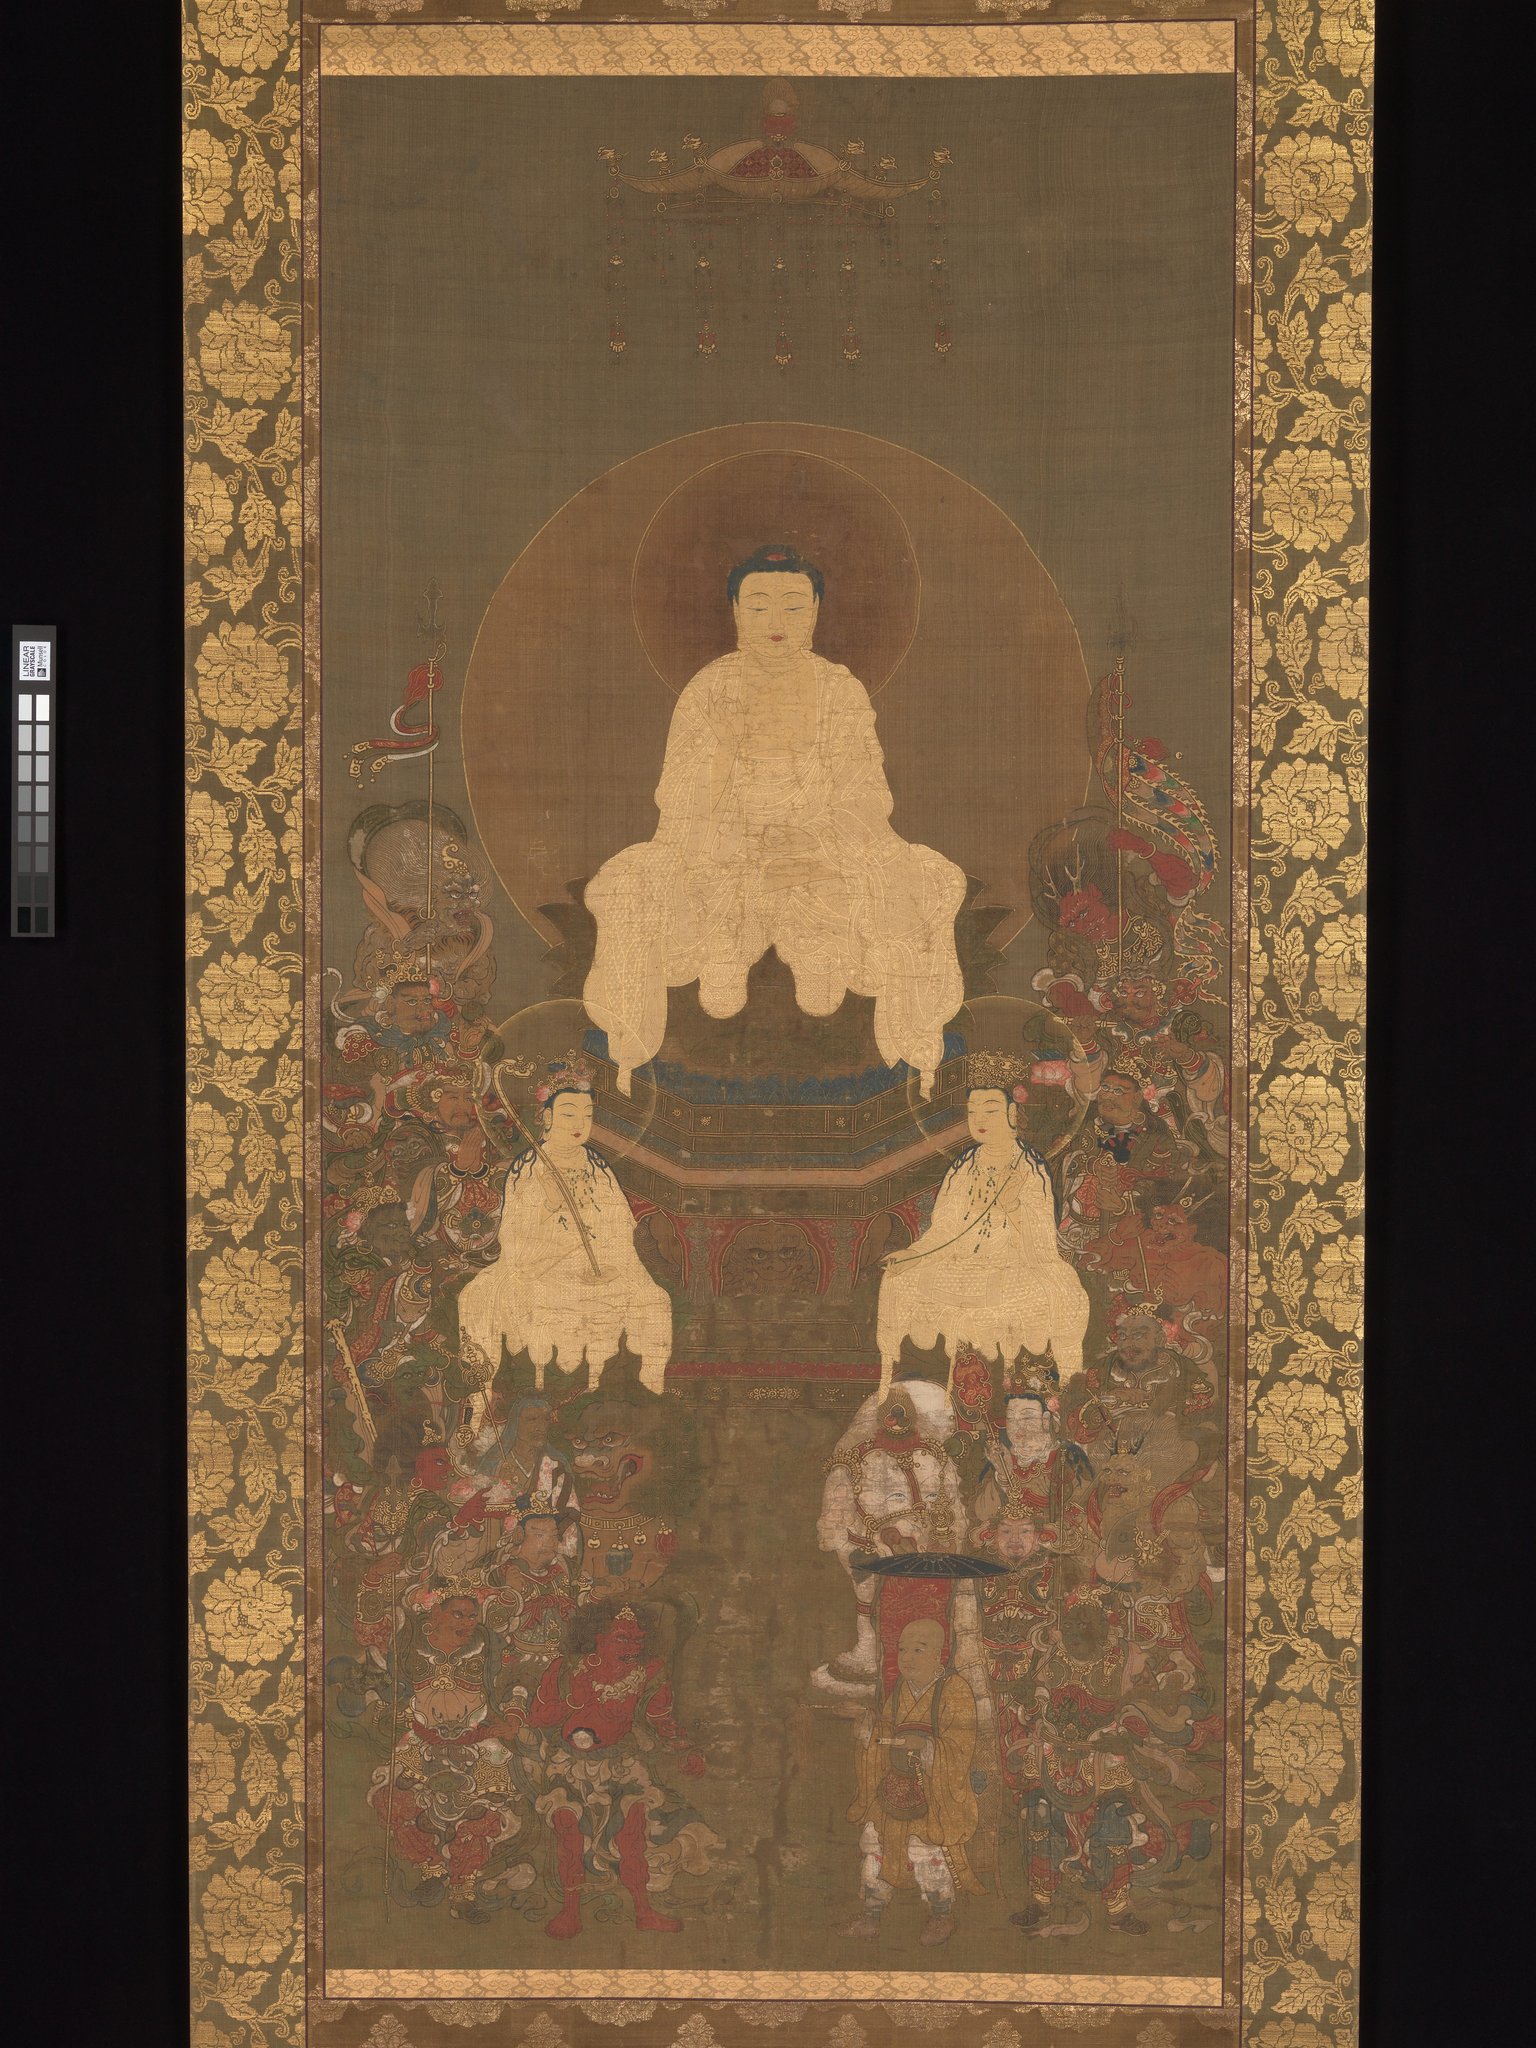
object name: hanging scroll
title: Shaka (Shakyamuni), the Historical Buddha, with Two Attendant Bodhisattvas and Sixteen Benevolent Deities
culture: japanese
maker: unidentified artist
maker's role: artist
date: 1367-1400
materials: gold, ink, silk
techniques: cutting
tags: elephants,lions,buddhism,buddha,shakyamuni,deities,monks